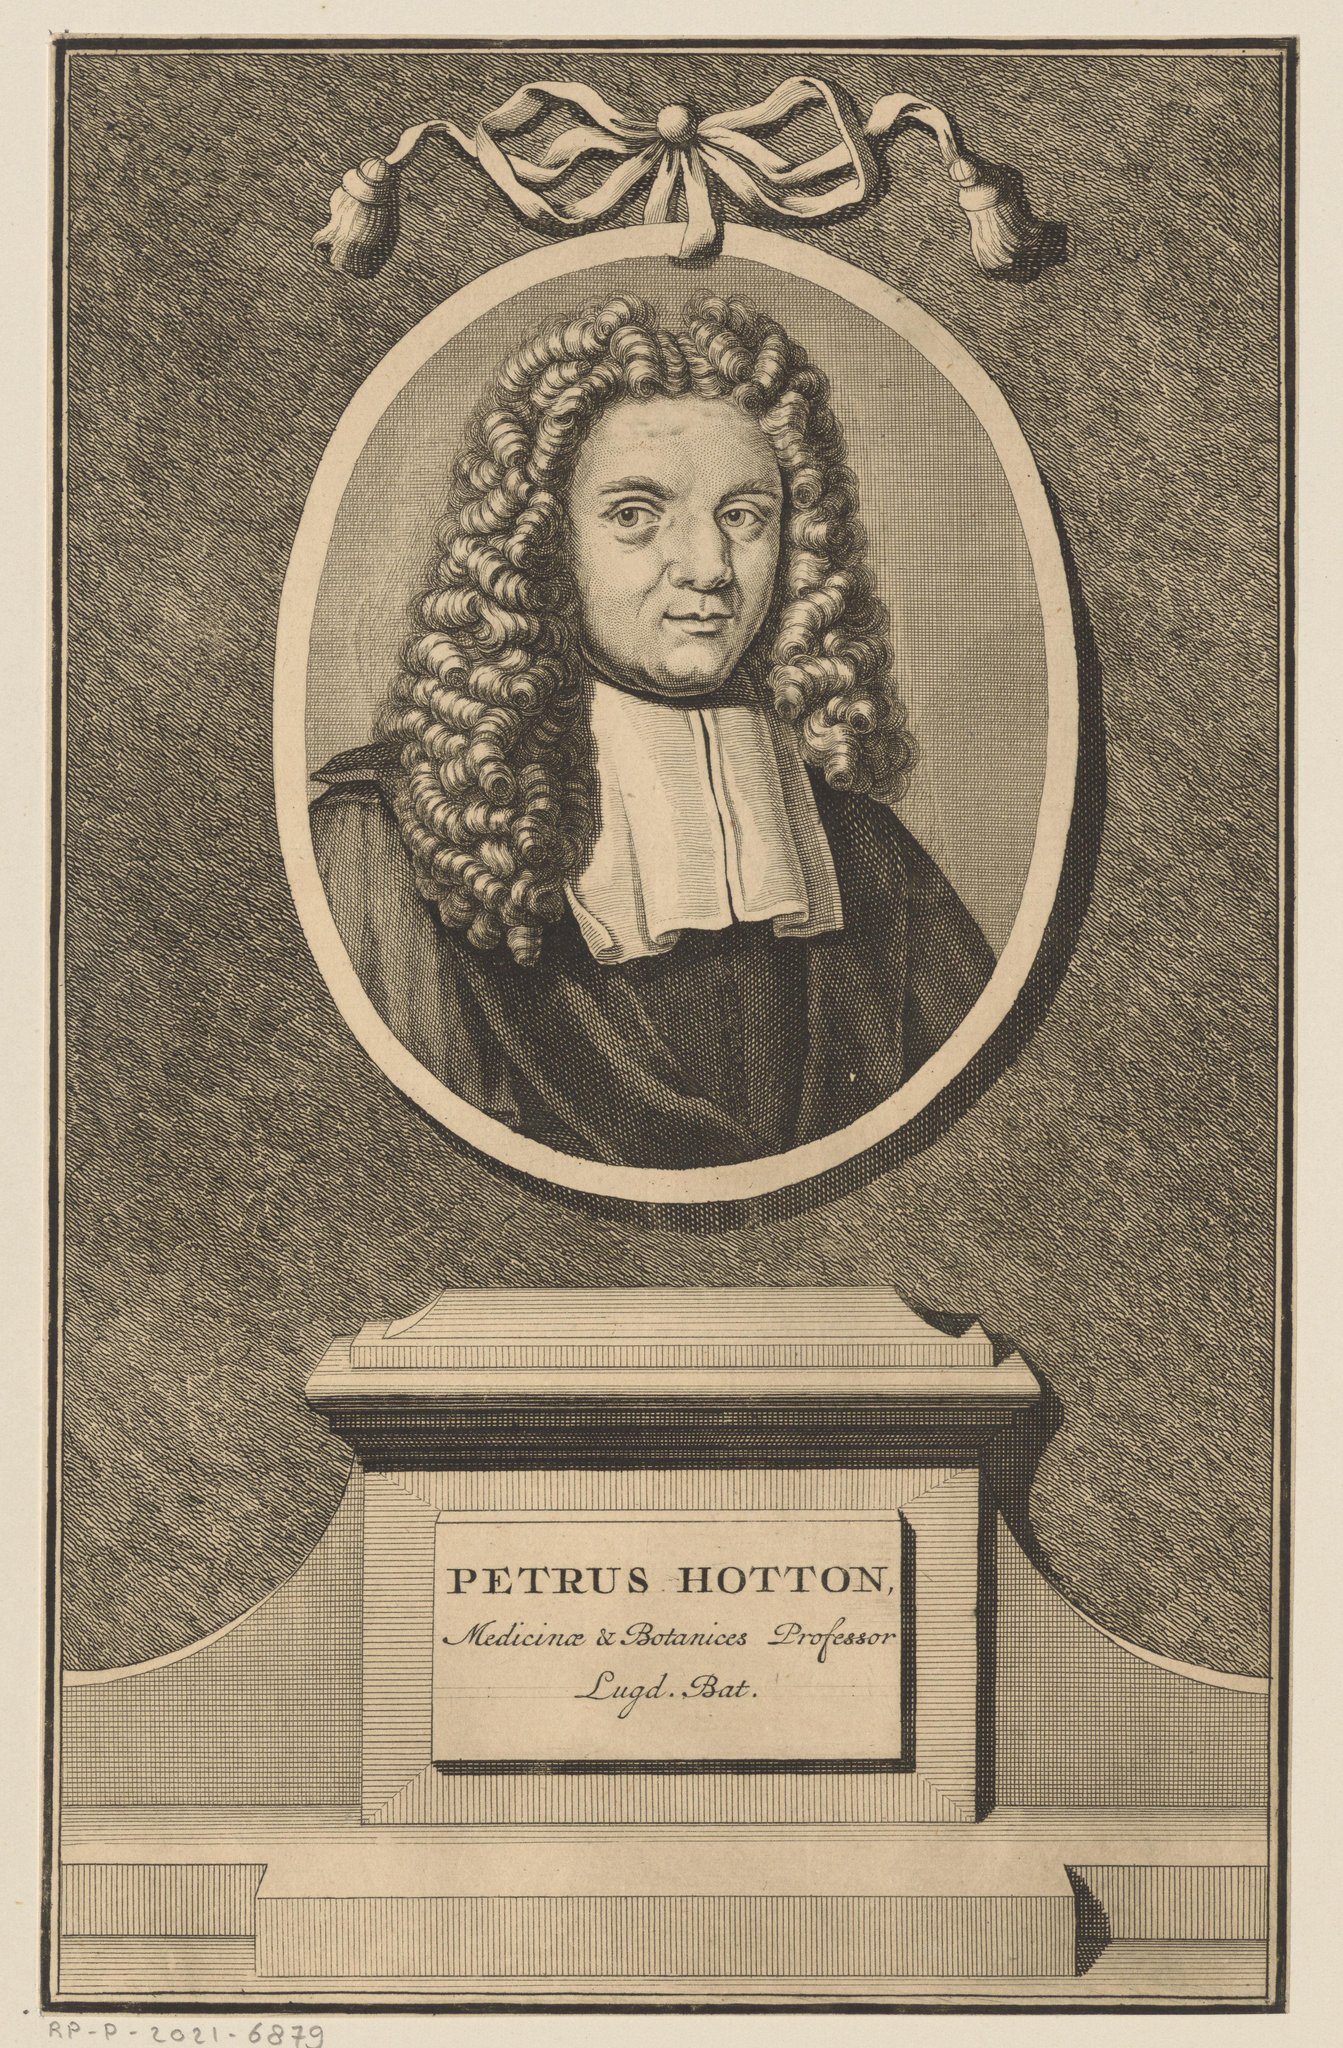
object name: print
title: Beroemde mannen aan de universiteit van Leiden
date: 1716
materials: paper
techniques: engraving, etching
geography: leiden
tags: amsterdam, leiden, historical persons, physician, doctor